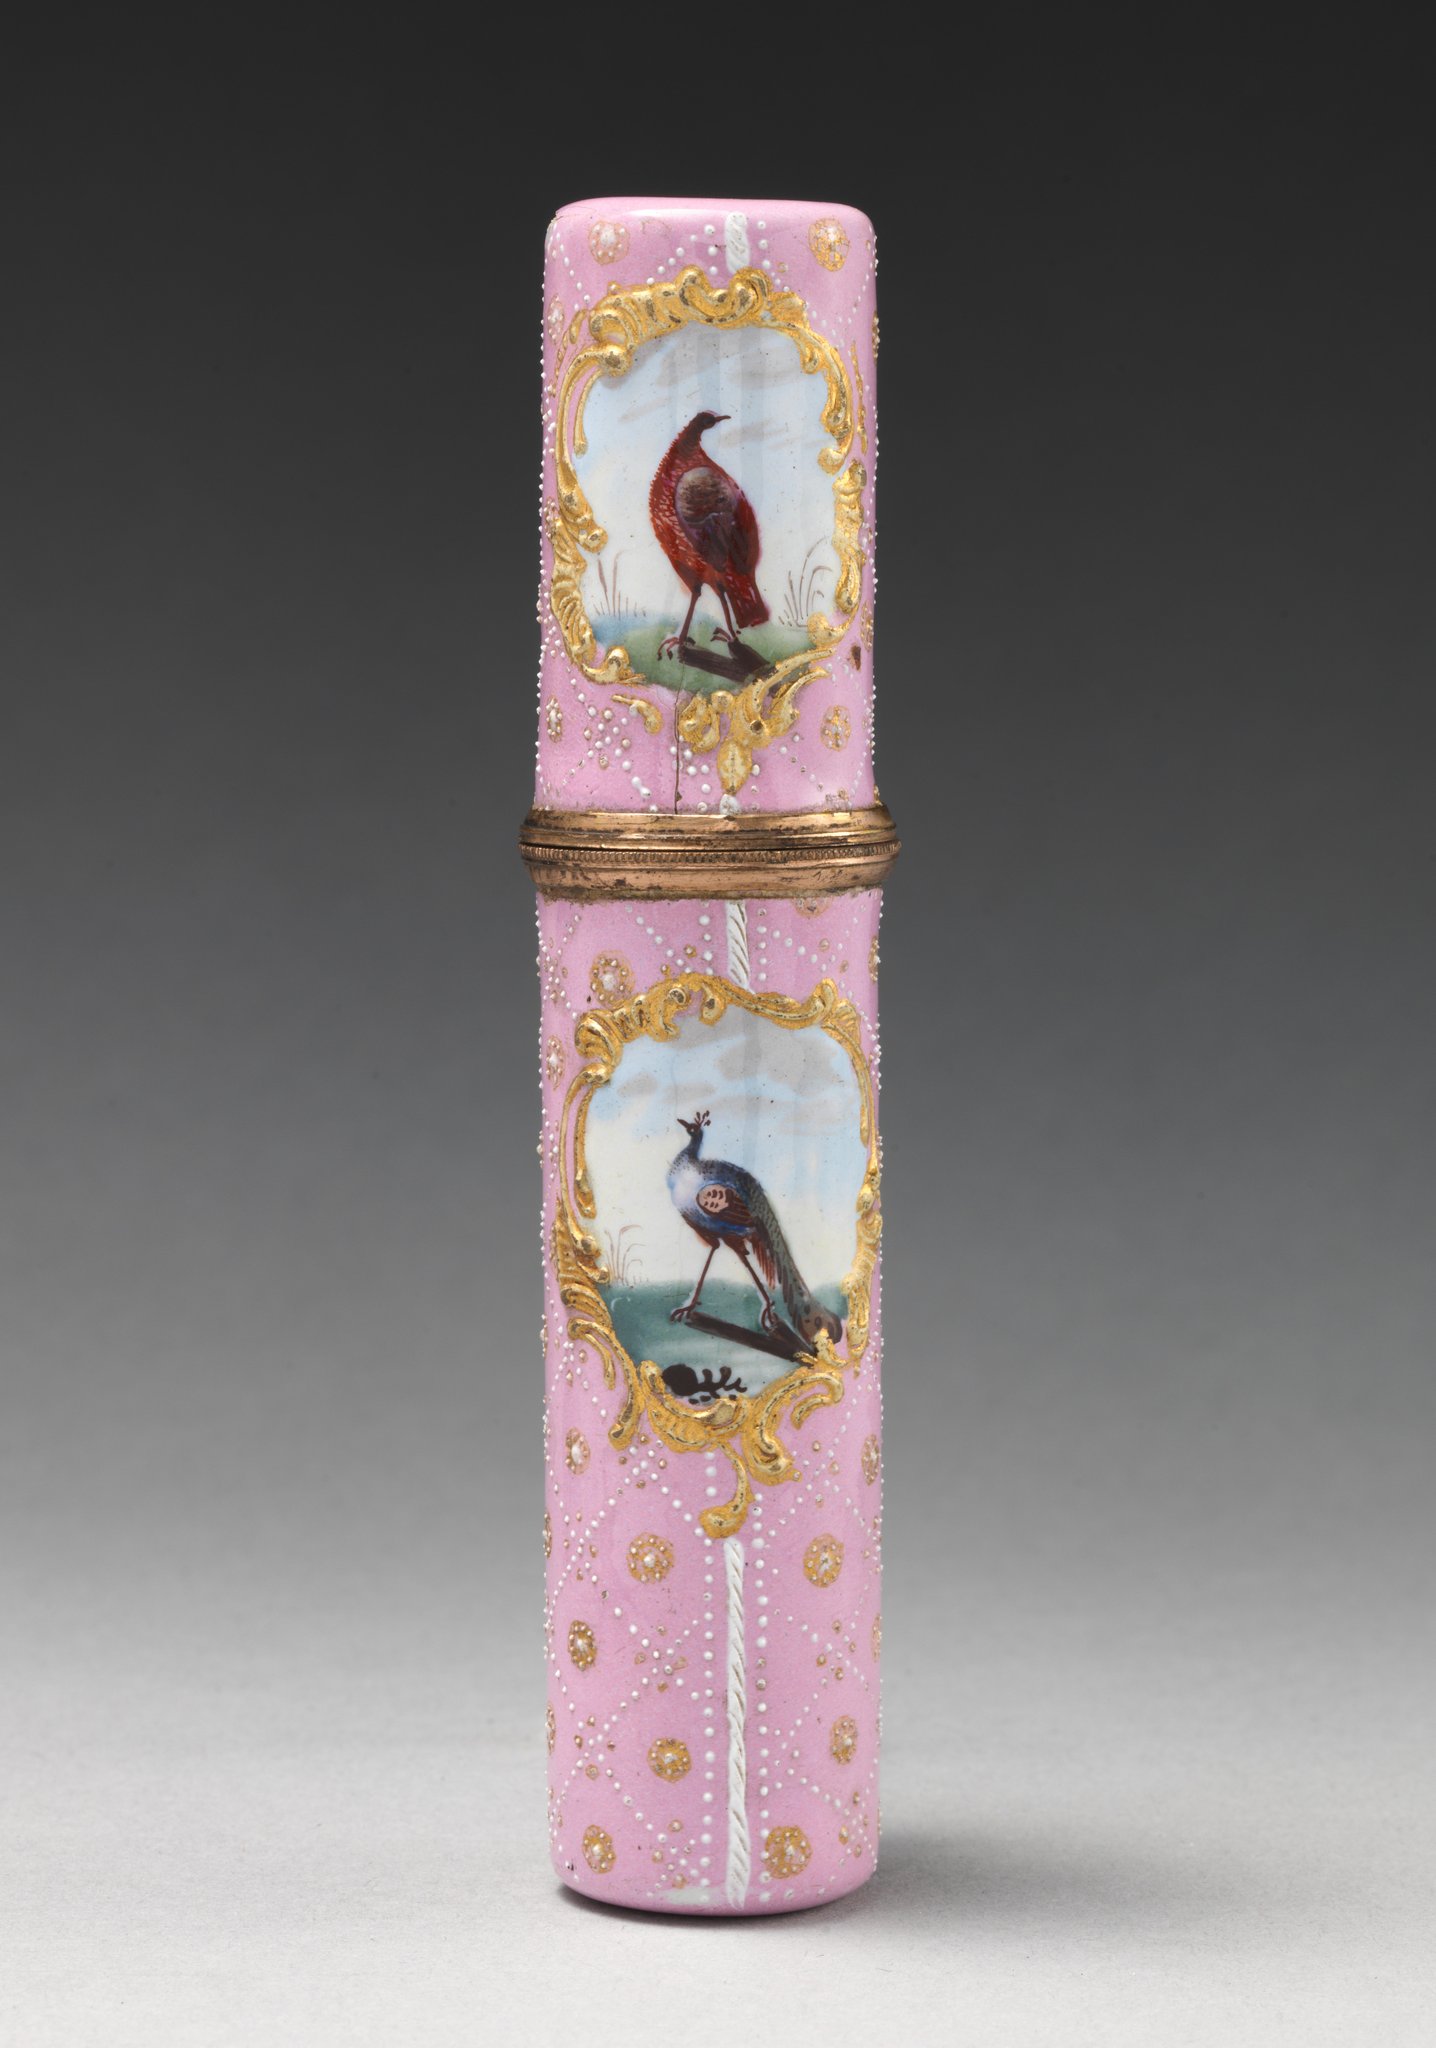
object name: étui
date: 1765-1770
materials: copper, enamel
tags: birds